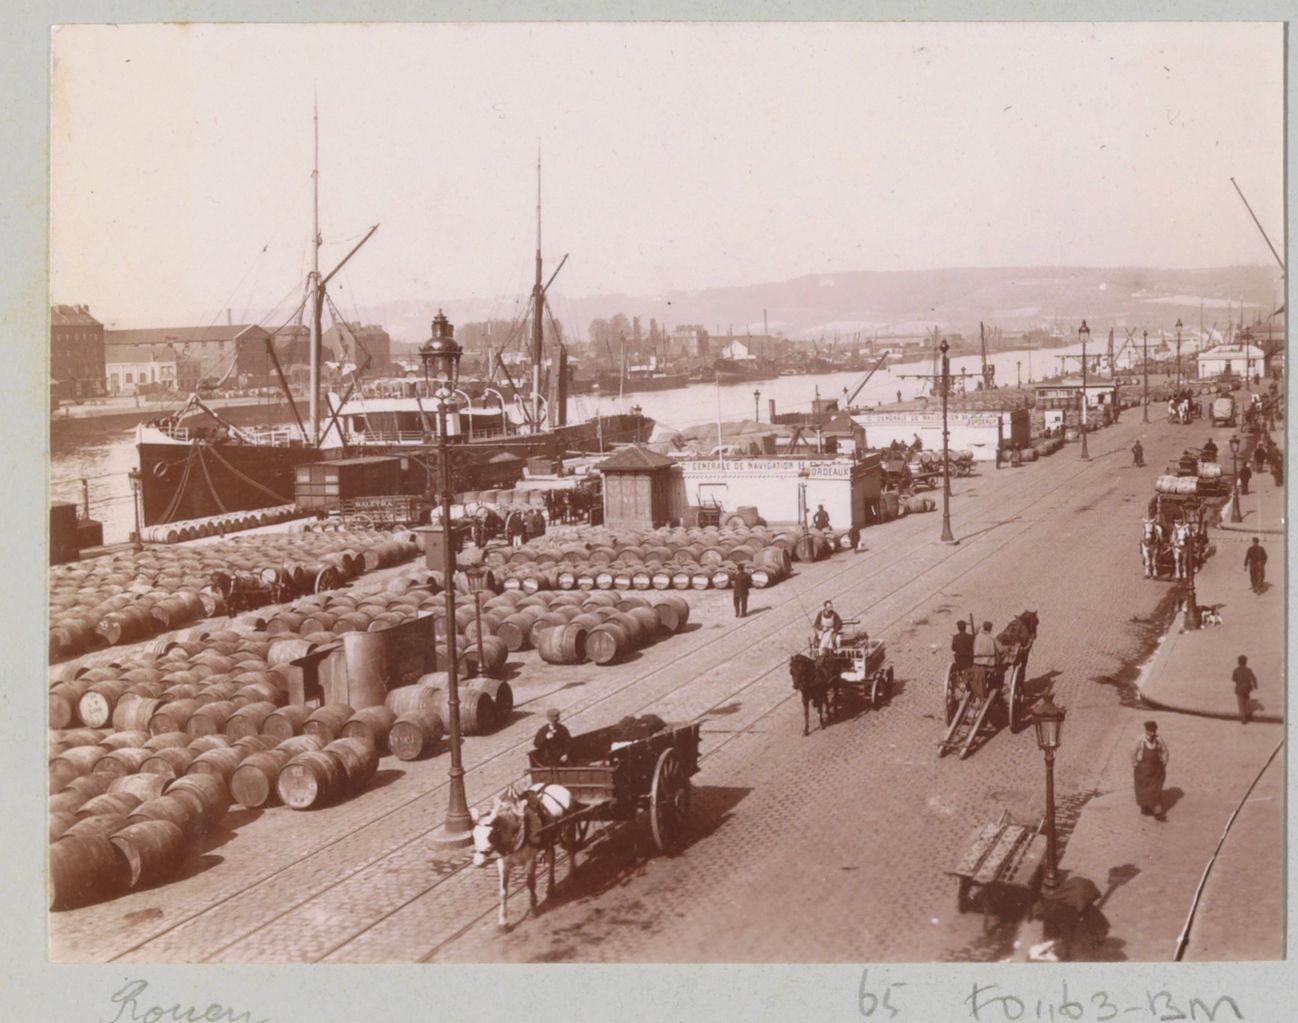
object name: photograph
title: Kade aan de Seine in Rouen met schepen, tonnen en paardenkarren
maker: delizy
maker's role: manufacturer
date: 1896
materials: paper, photographic support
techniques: gelatin silver print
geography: rouen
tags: wooden container: barrel, cask (+ wood and other phytogenic material), two-wheeled, animal-drawn vehicle, quay (+ city(-scape) with figures, staffage)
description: Onderdeel van Fotoalbum van een Franse amateurfotograaf met opnames van uitstapjes in Frankrijk, Spanje, België, Luxemburg en Nederland, de eerste automobielen en autoraces.